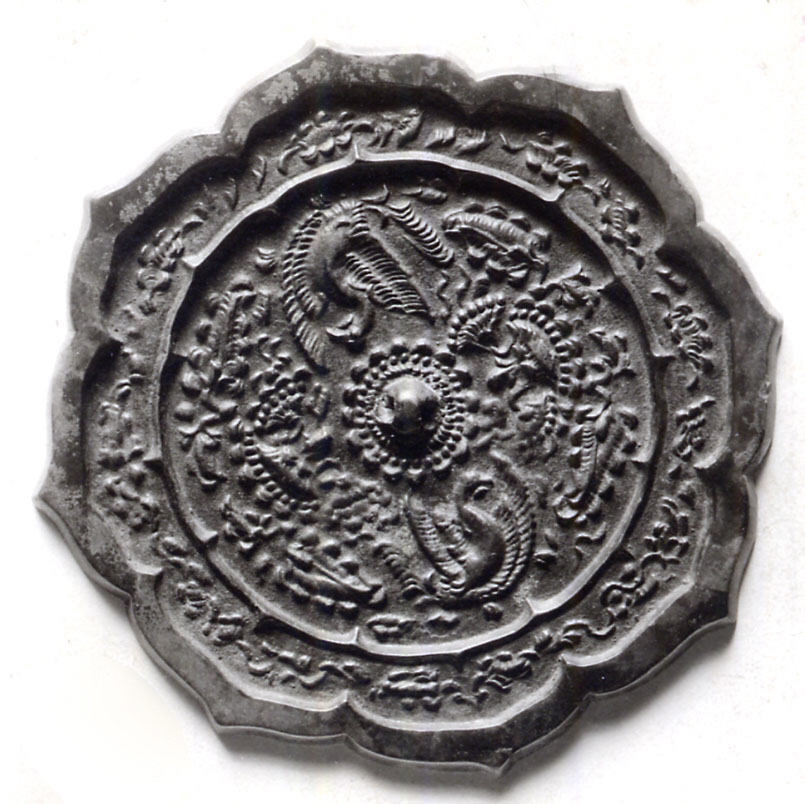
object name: mirror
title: Mirror with paired birds and flowers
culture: chinese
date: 801-900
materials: bronze